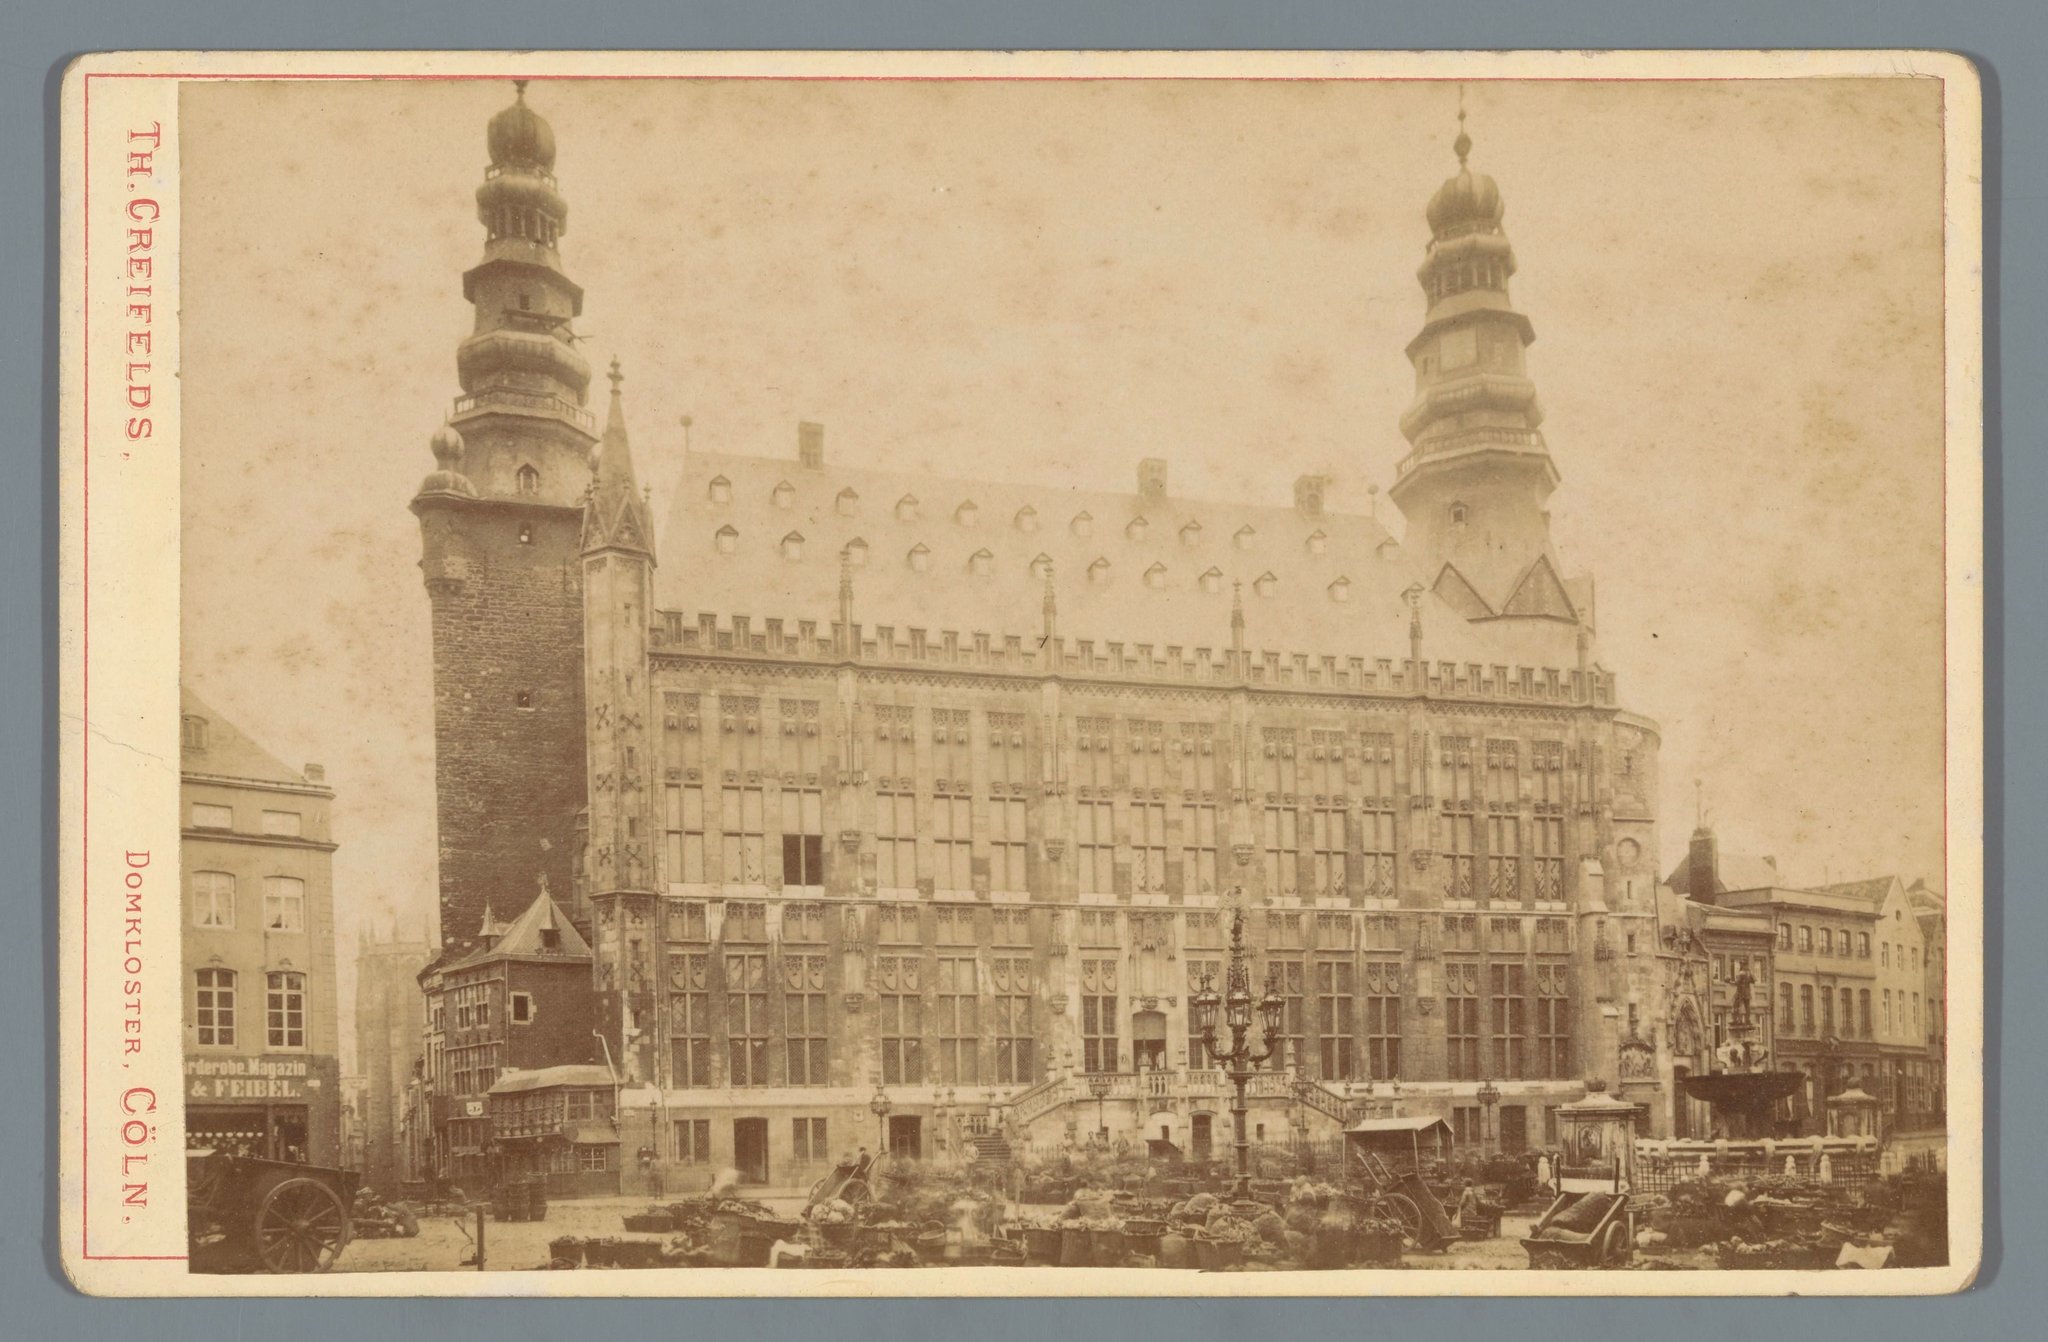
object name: photograph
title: Domkloster, Cöln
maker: theodor creifelds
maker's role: publisher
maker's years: 1815-1875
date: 1859-1875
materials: cardboard, photographic support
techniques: albumen print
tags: façade (of house or building)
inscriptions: annotation: ‘Bremen?’